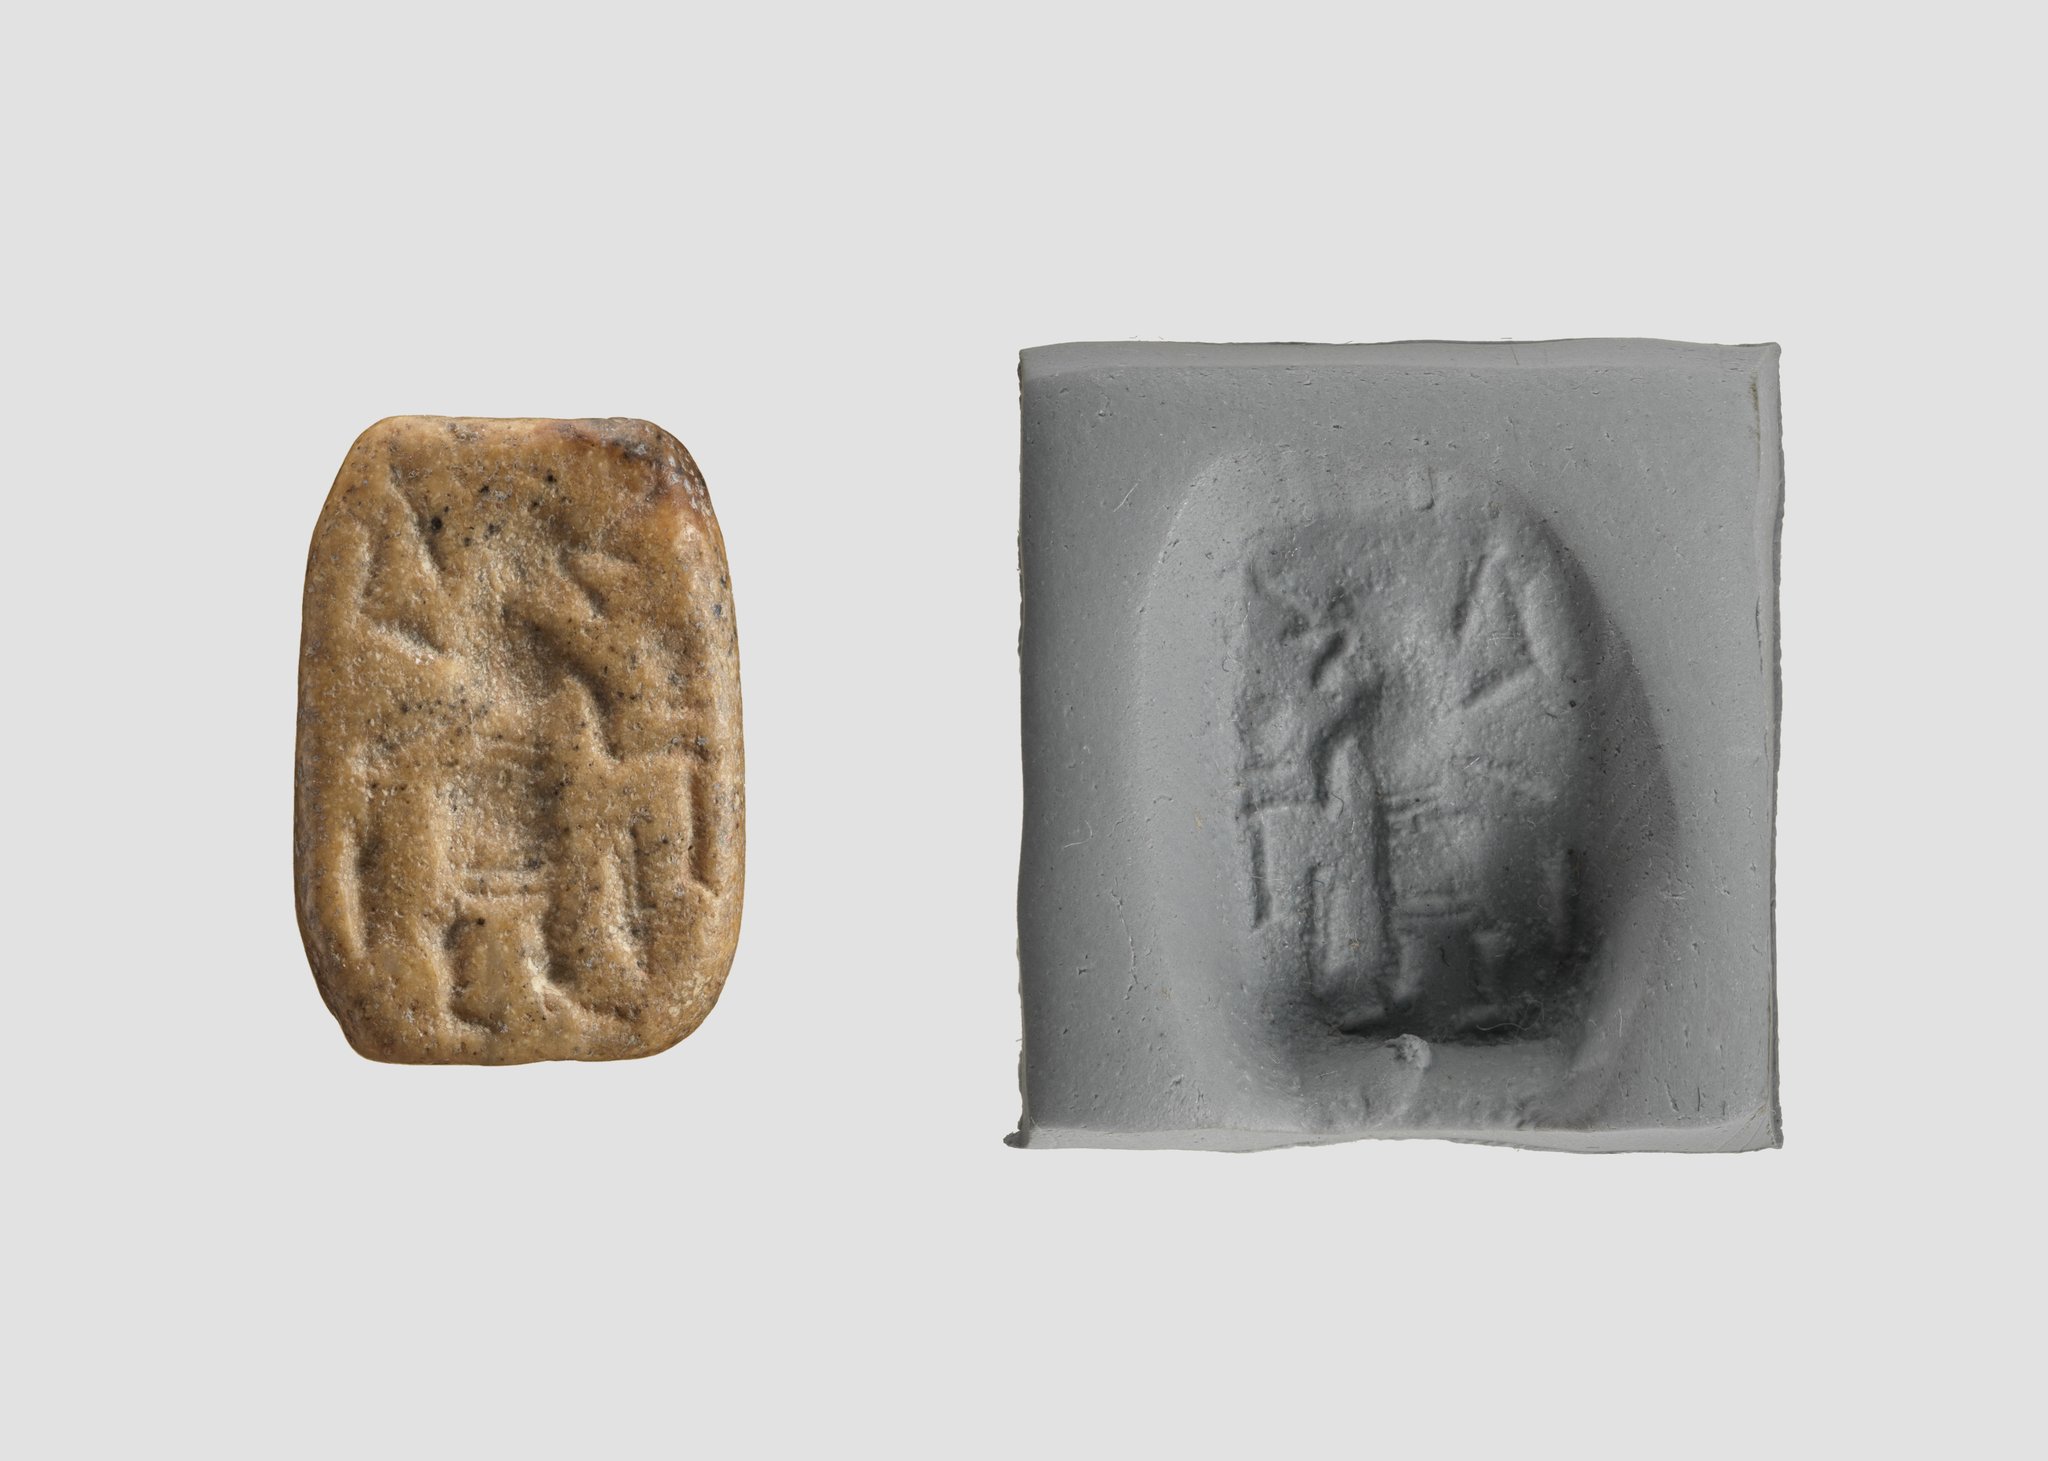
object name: stamp seal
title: Stamp seal (octagonal pyramid) with demon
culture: assyrian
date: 734-601 BCE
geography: mesopotamia or syria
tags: demons